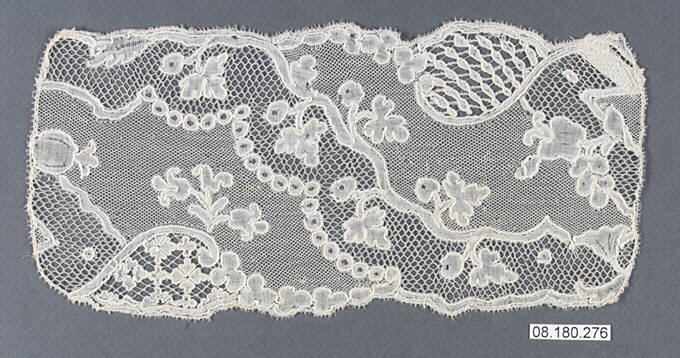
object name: fragment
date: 1701-1800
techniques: lace